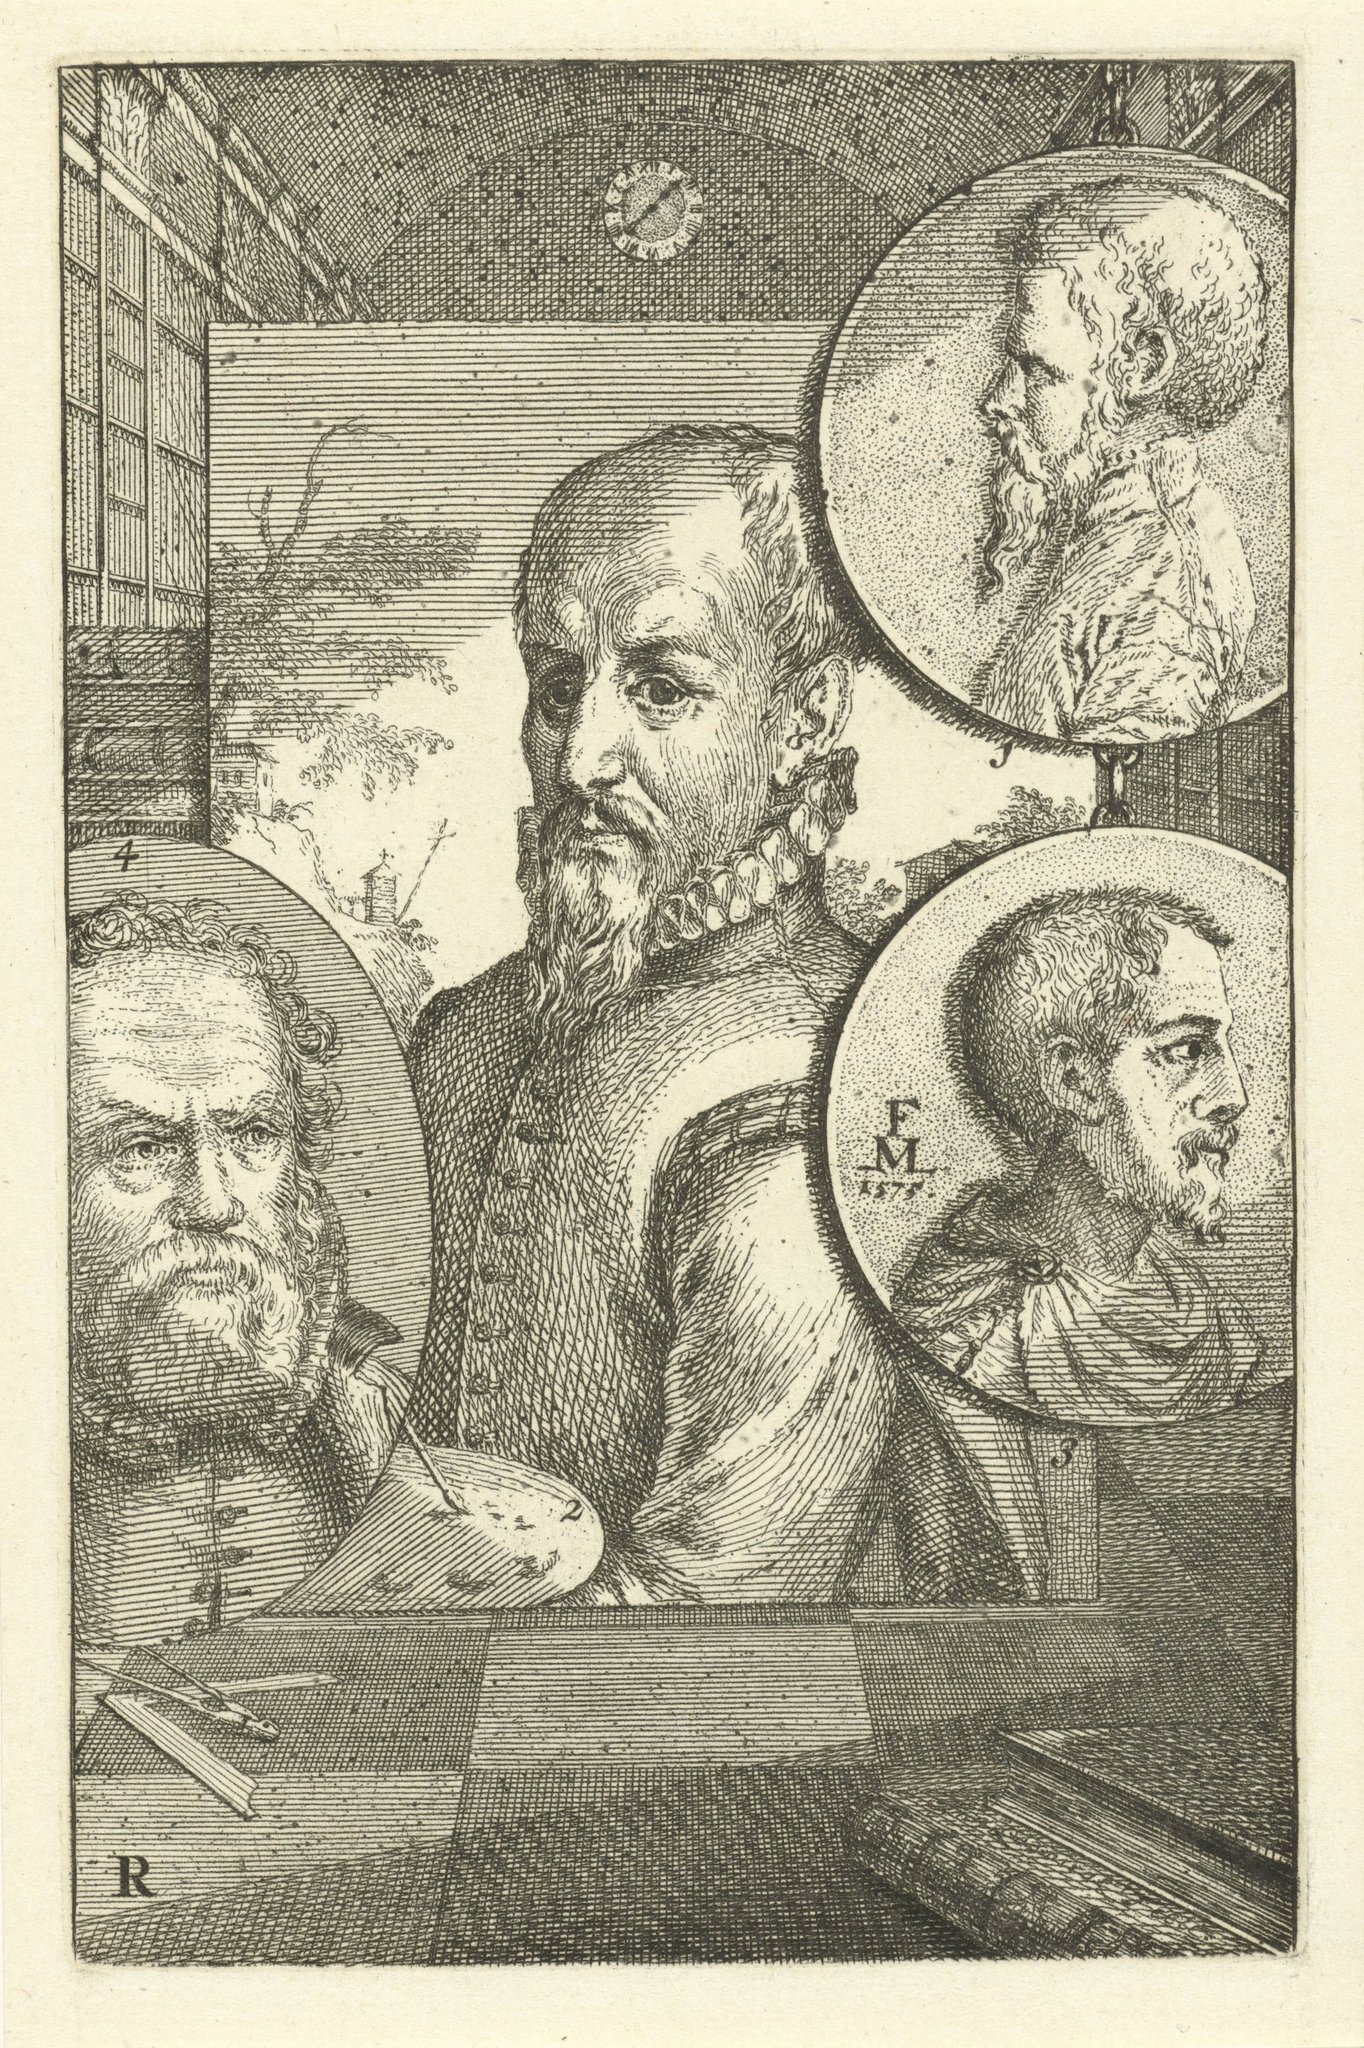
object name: book illustration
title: Portretten van Augustin Jorisz. Verburcht, Hendrick van Cleve, Melchior Lorck en Hans Vredeman de Vries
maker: jan l admiral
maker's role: draughtsman, print maker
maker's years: 1699-1773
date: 1764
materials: paper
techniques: etching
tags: melchior lorck, hendrick van cleve, hans vredeman de vries, painter, print maker, augustin jorisz. verburcht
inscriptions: collector's mark: Lugt 2228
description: Vier genummerde kunstenaarsportretten. Portret van Augustin Jorisz. Verburcht (nr. 1), Hendrick van Cleve (nr. 2), Melchior Lorck (nr. 3) en Hans Vredeman de Vries (nr. 4). Prent linksonder gemerkt: R.